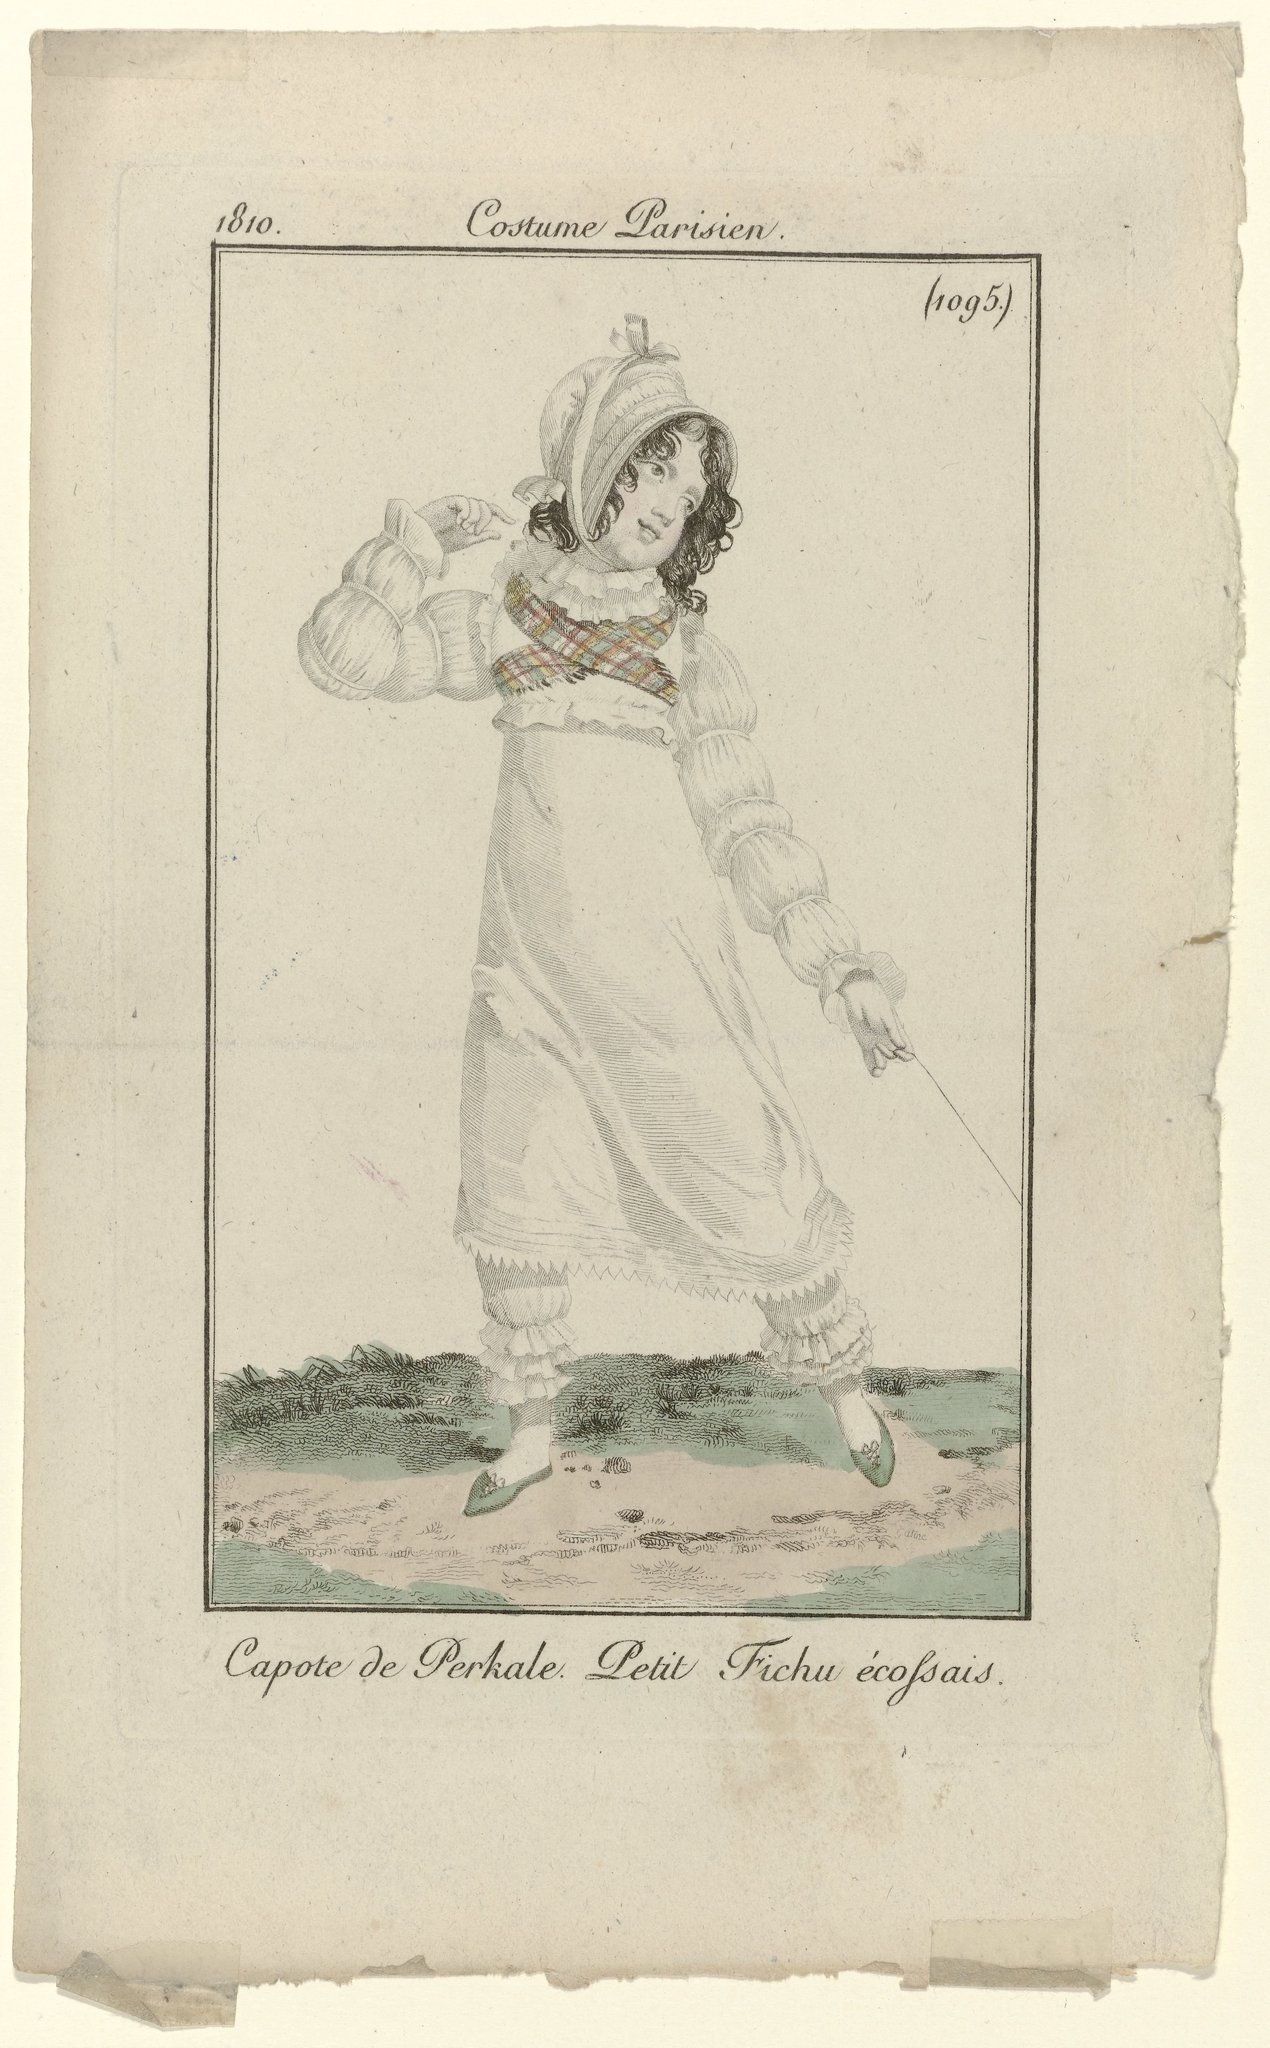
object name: fashion print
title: Journal des Dames et des Modes, Costume Parisien, 15 octobre 1810, (1095): Capote de Perkal (...)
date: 1810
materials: paper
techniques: engraving, hand coloring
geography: paris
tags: stockings, socks (+ girls' clothes), shoes, sandals (+ girls' clothes), underclothes for the lower part of the body: bloomers (+ girls' clothes), sleeves (+ girls' clothes), head-gear (capote) (+ girls' clothes), piece of clothing covering the breast or décolleté (fichu) (+ girls' clothes), fashion plates, dress, gown (+ girls' clothes)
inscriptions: caption: ‘Capote de Perkale. Petit Fichu écosais.’, title: ‘Costume Parisien.’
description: Meisje, lopend naar links, met op het hoofd een 'capote' van katoenbatist (percale). Kleine geruite fichu om de hals. Zij draagt een japon met mamelukkenmouwen op een lange broek(bloomers) versierd met drie geplooide stroken stof. platte schoenen met strikken. De prent maakt deel uit van het modetijdschrift Journal des Dames et des Modes, uitgegeven door Pierre de la Mésangère, Parijs, 1797-1839.